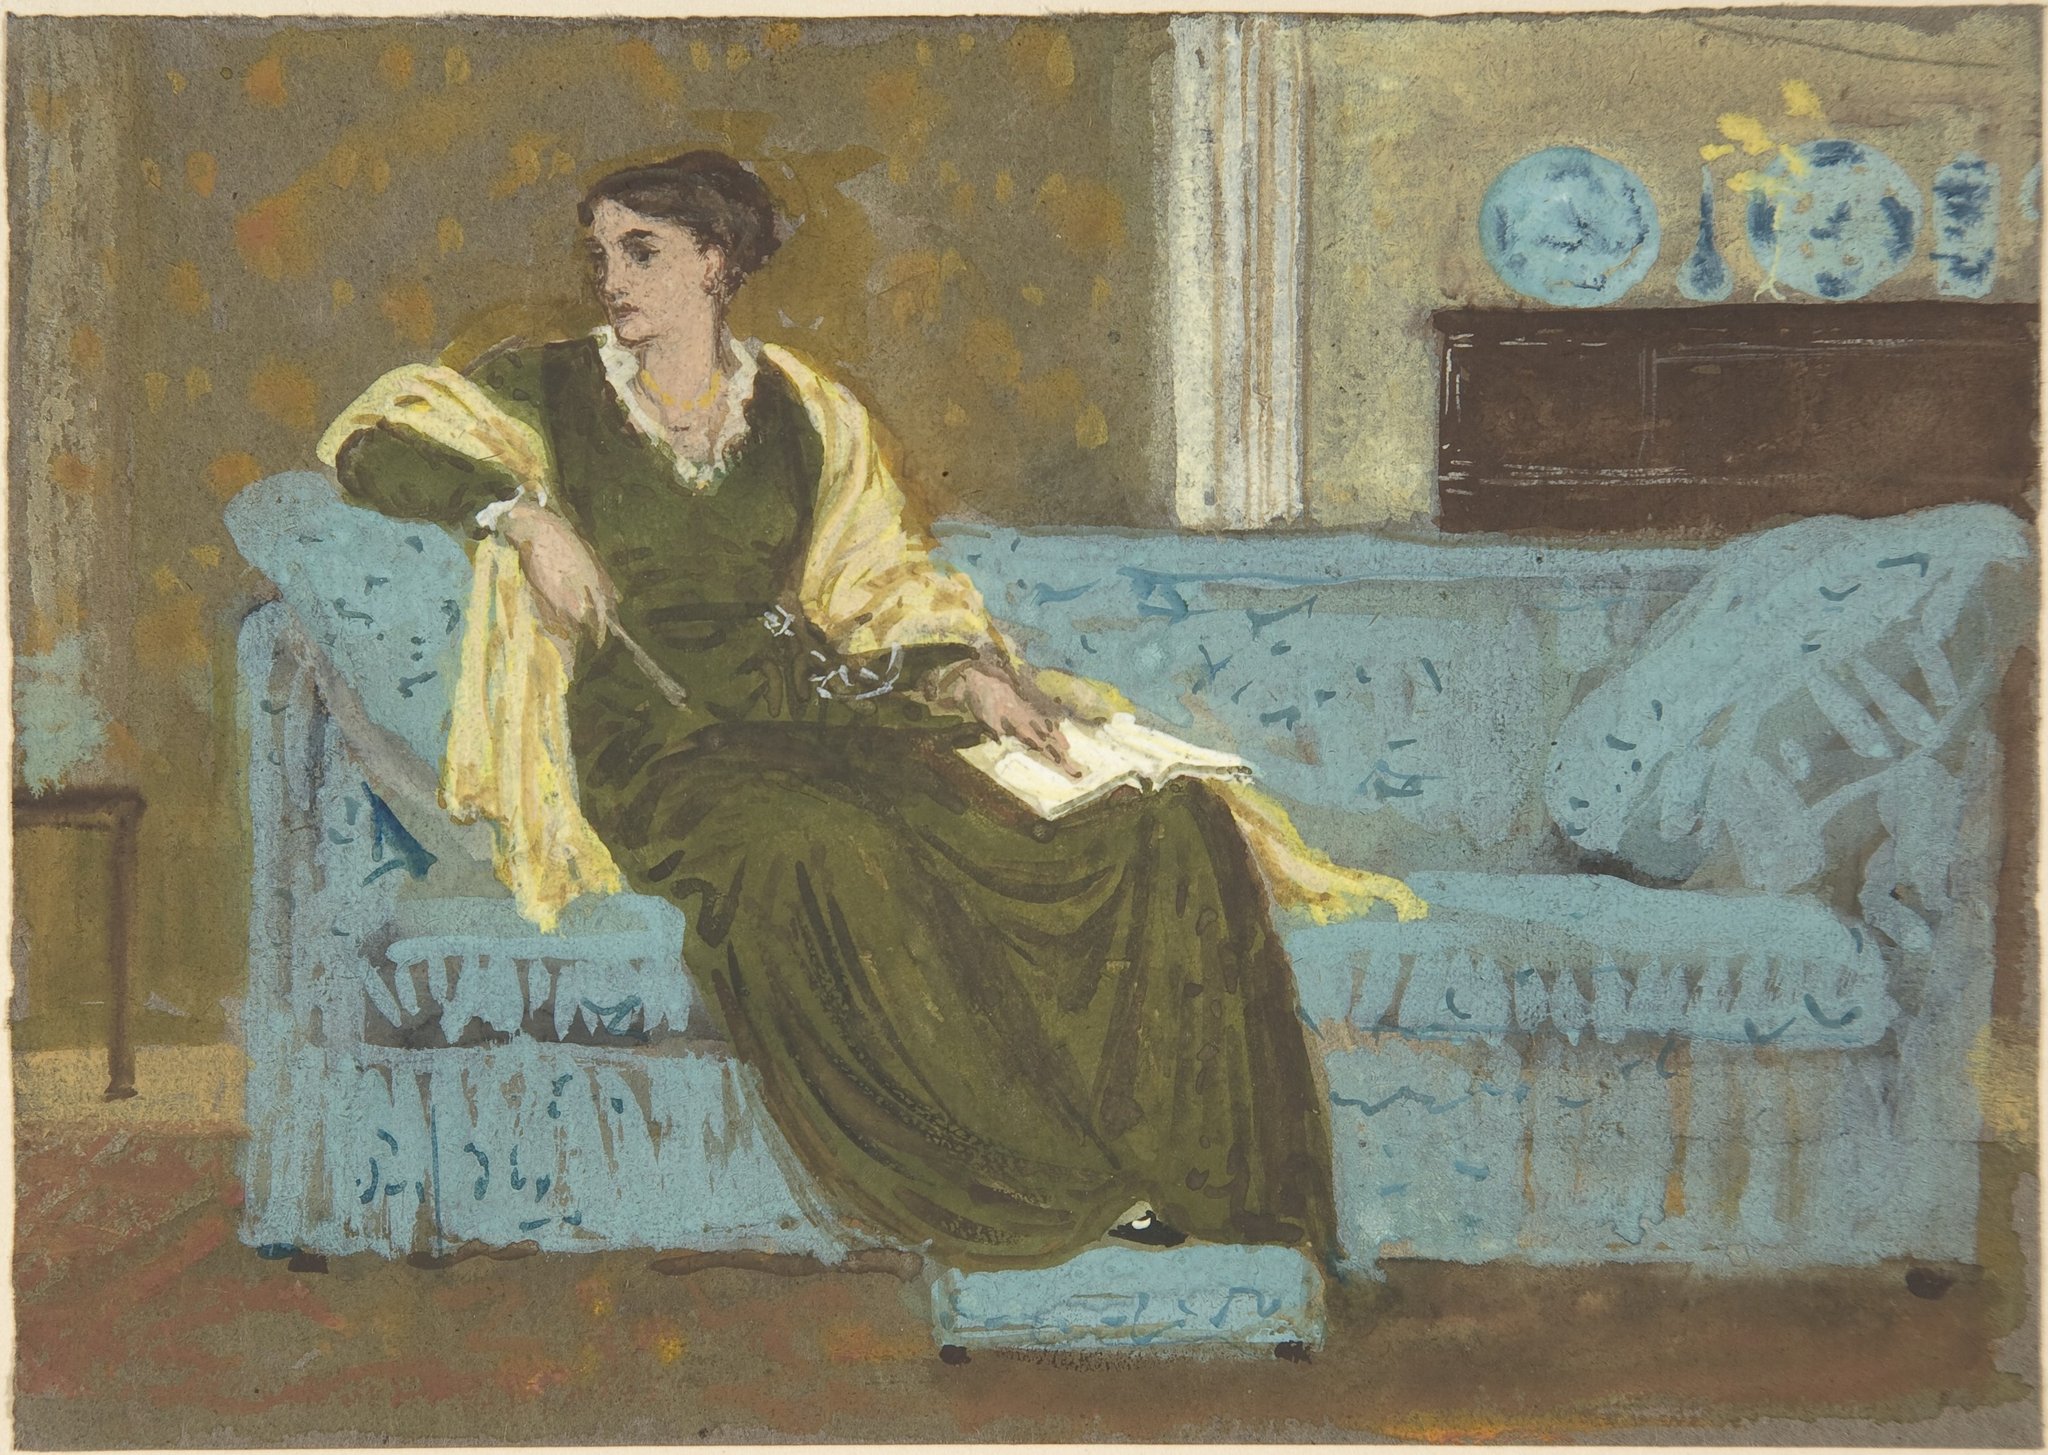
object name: drawing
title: Woman Seated on a Sofa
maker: walter crane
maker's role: artist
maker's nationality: british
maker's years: 1845-1915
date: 1865-1915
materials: gouache, graphite, watercolor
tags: women,couches